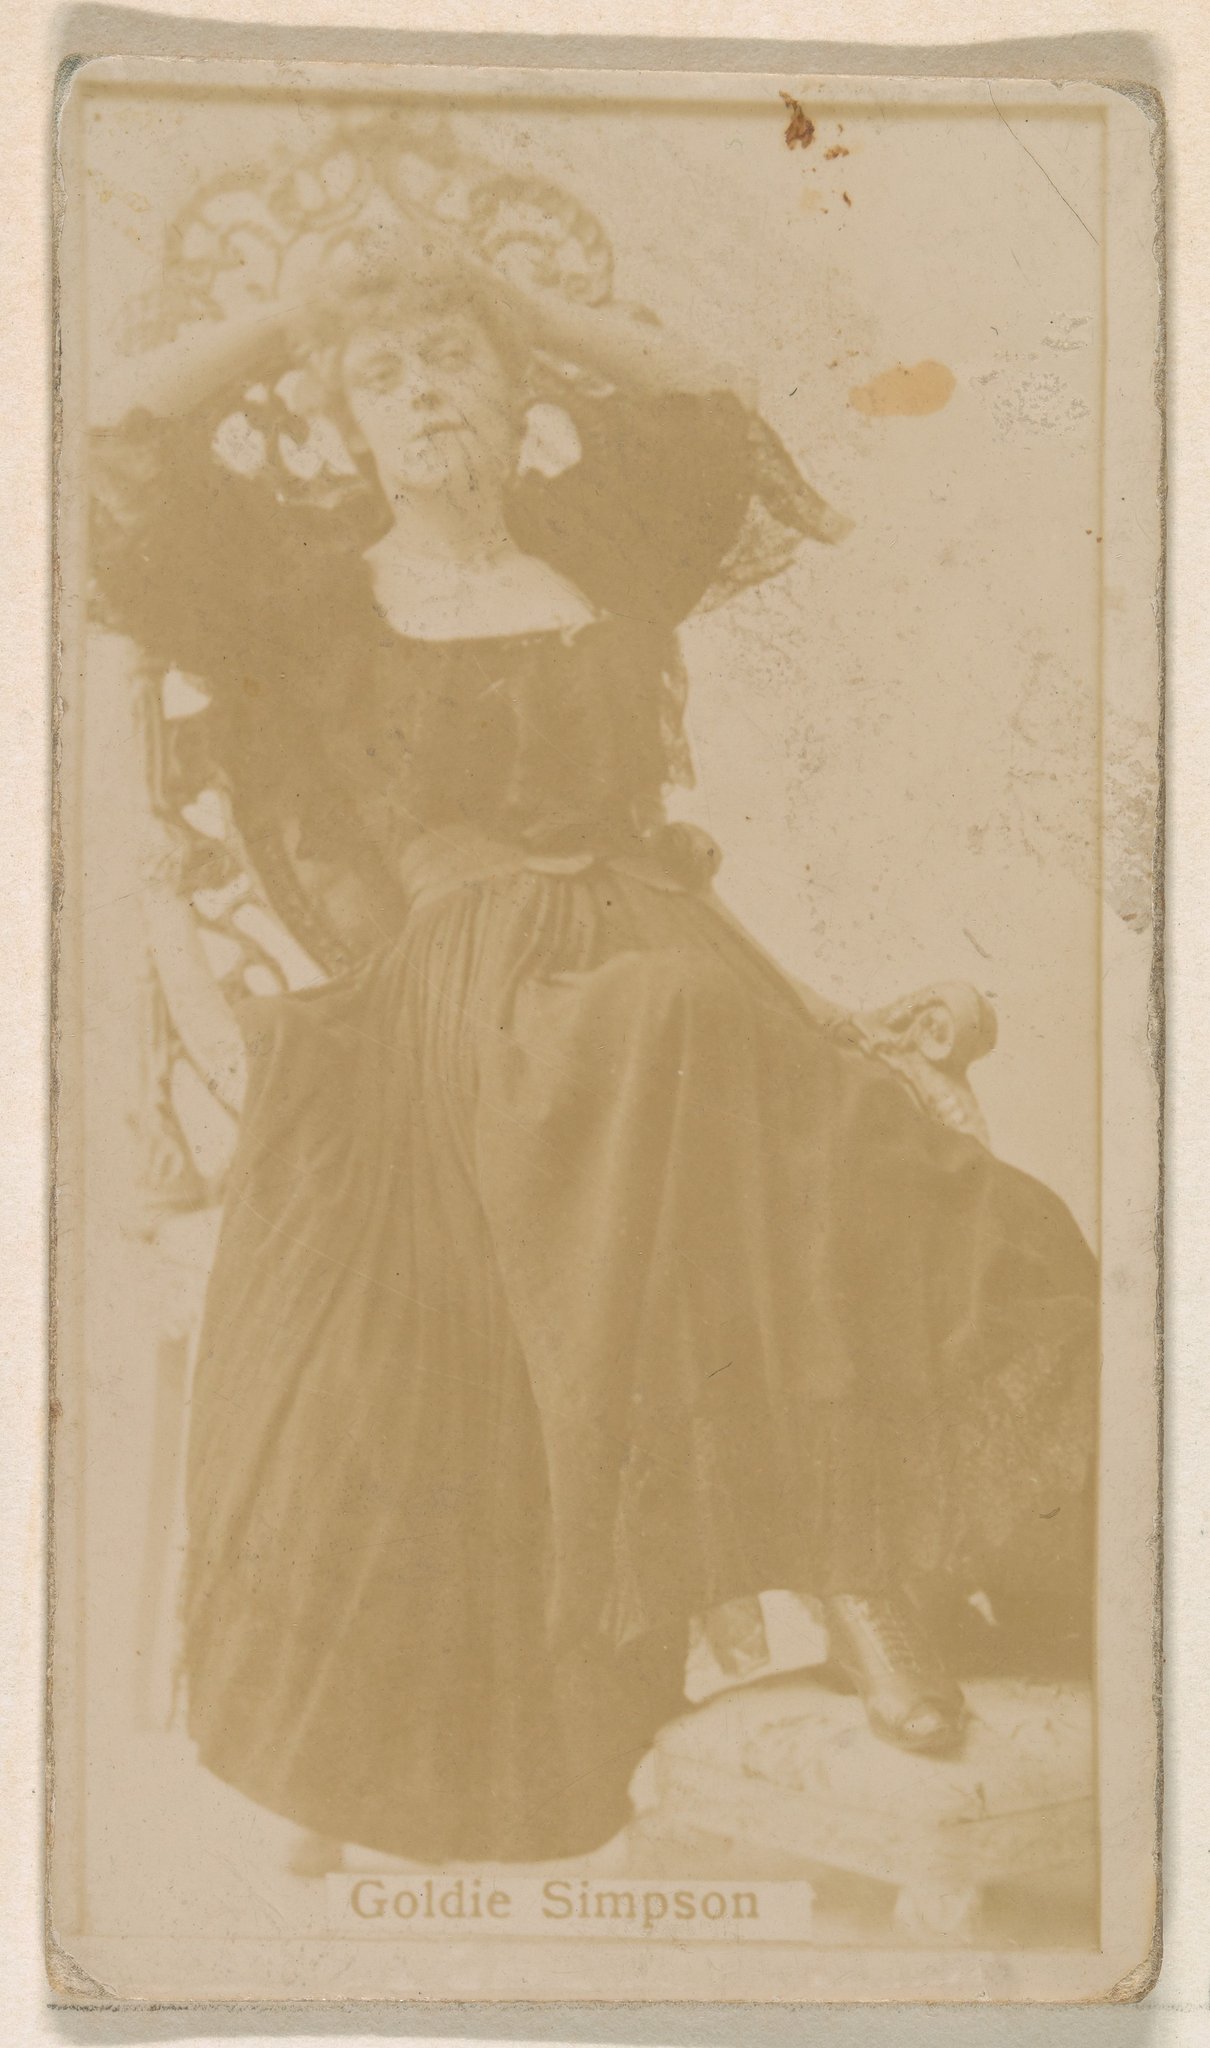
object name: photograph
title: Goldie Simpson, from the Actresses series (N245) issued by Kinney Brothers to promote Sweet Caporal Cigarettes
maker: kinney brothers tobacco company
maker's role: publisher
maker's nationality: american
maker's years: 1869-2011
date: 1890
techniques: albumen silver print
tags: portraits,women,actresses